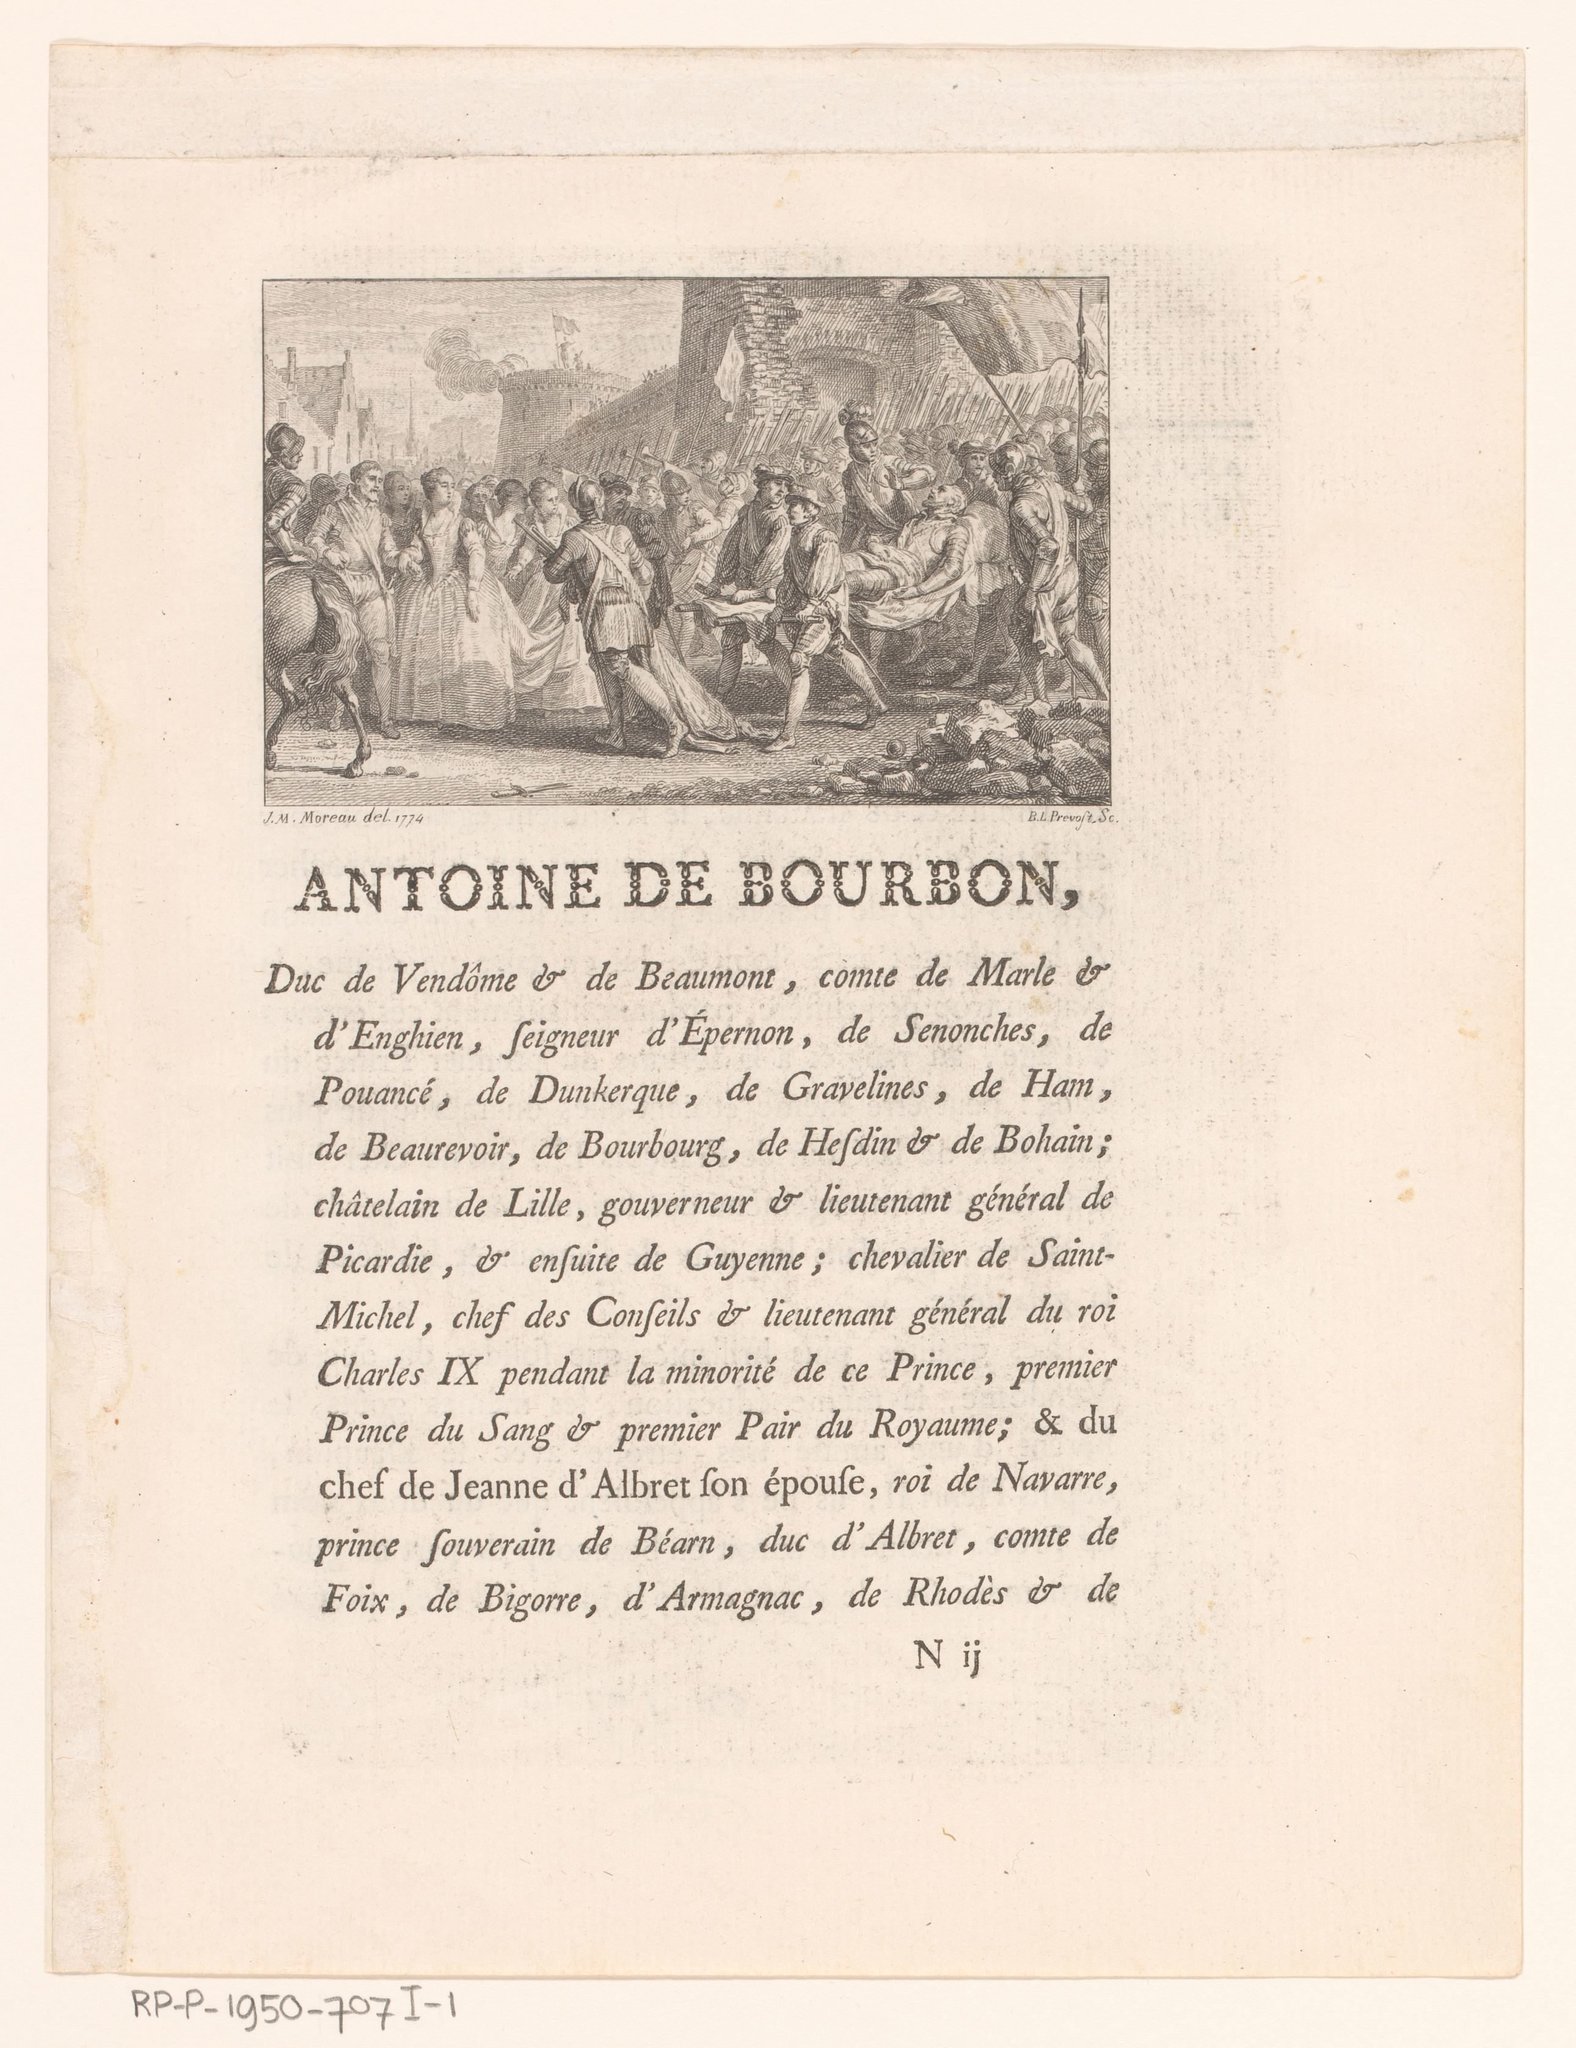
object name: book illustration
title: Koning Antoine de Bourbon wordt gewond weggedragen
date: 1782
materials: paper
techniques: engraving, etching, letterpress printing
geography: paris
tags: antoine de bourbon (koning van navarra), carrying the sick, wounded and dead off the battle-field, king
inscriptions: collector's mark: Lugt 2228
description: Prent uit: Désormeaux, Joseph-Louis-Ripault. Histoire de la maison de Bourbon. Parijs: L'Imprimerie Royale, 1782, dl. 3, p. 99.